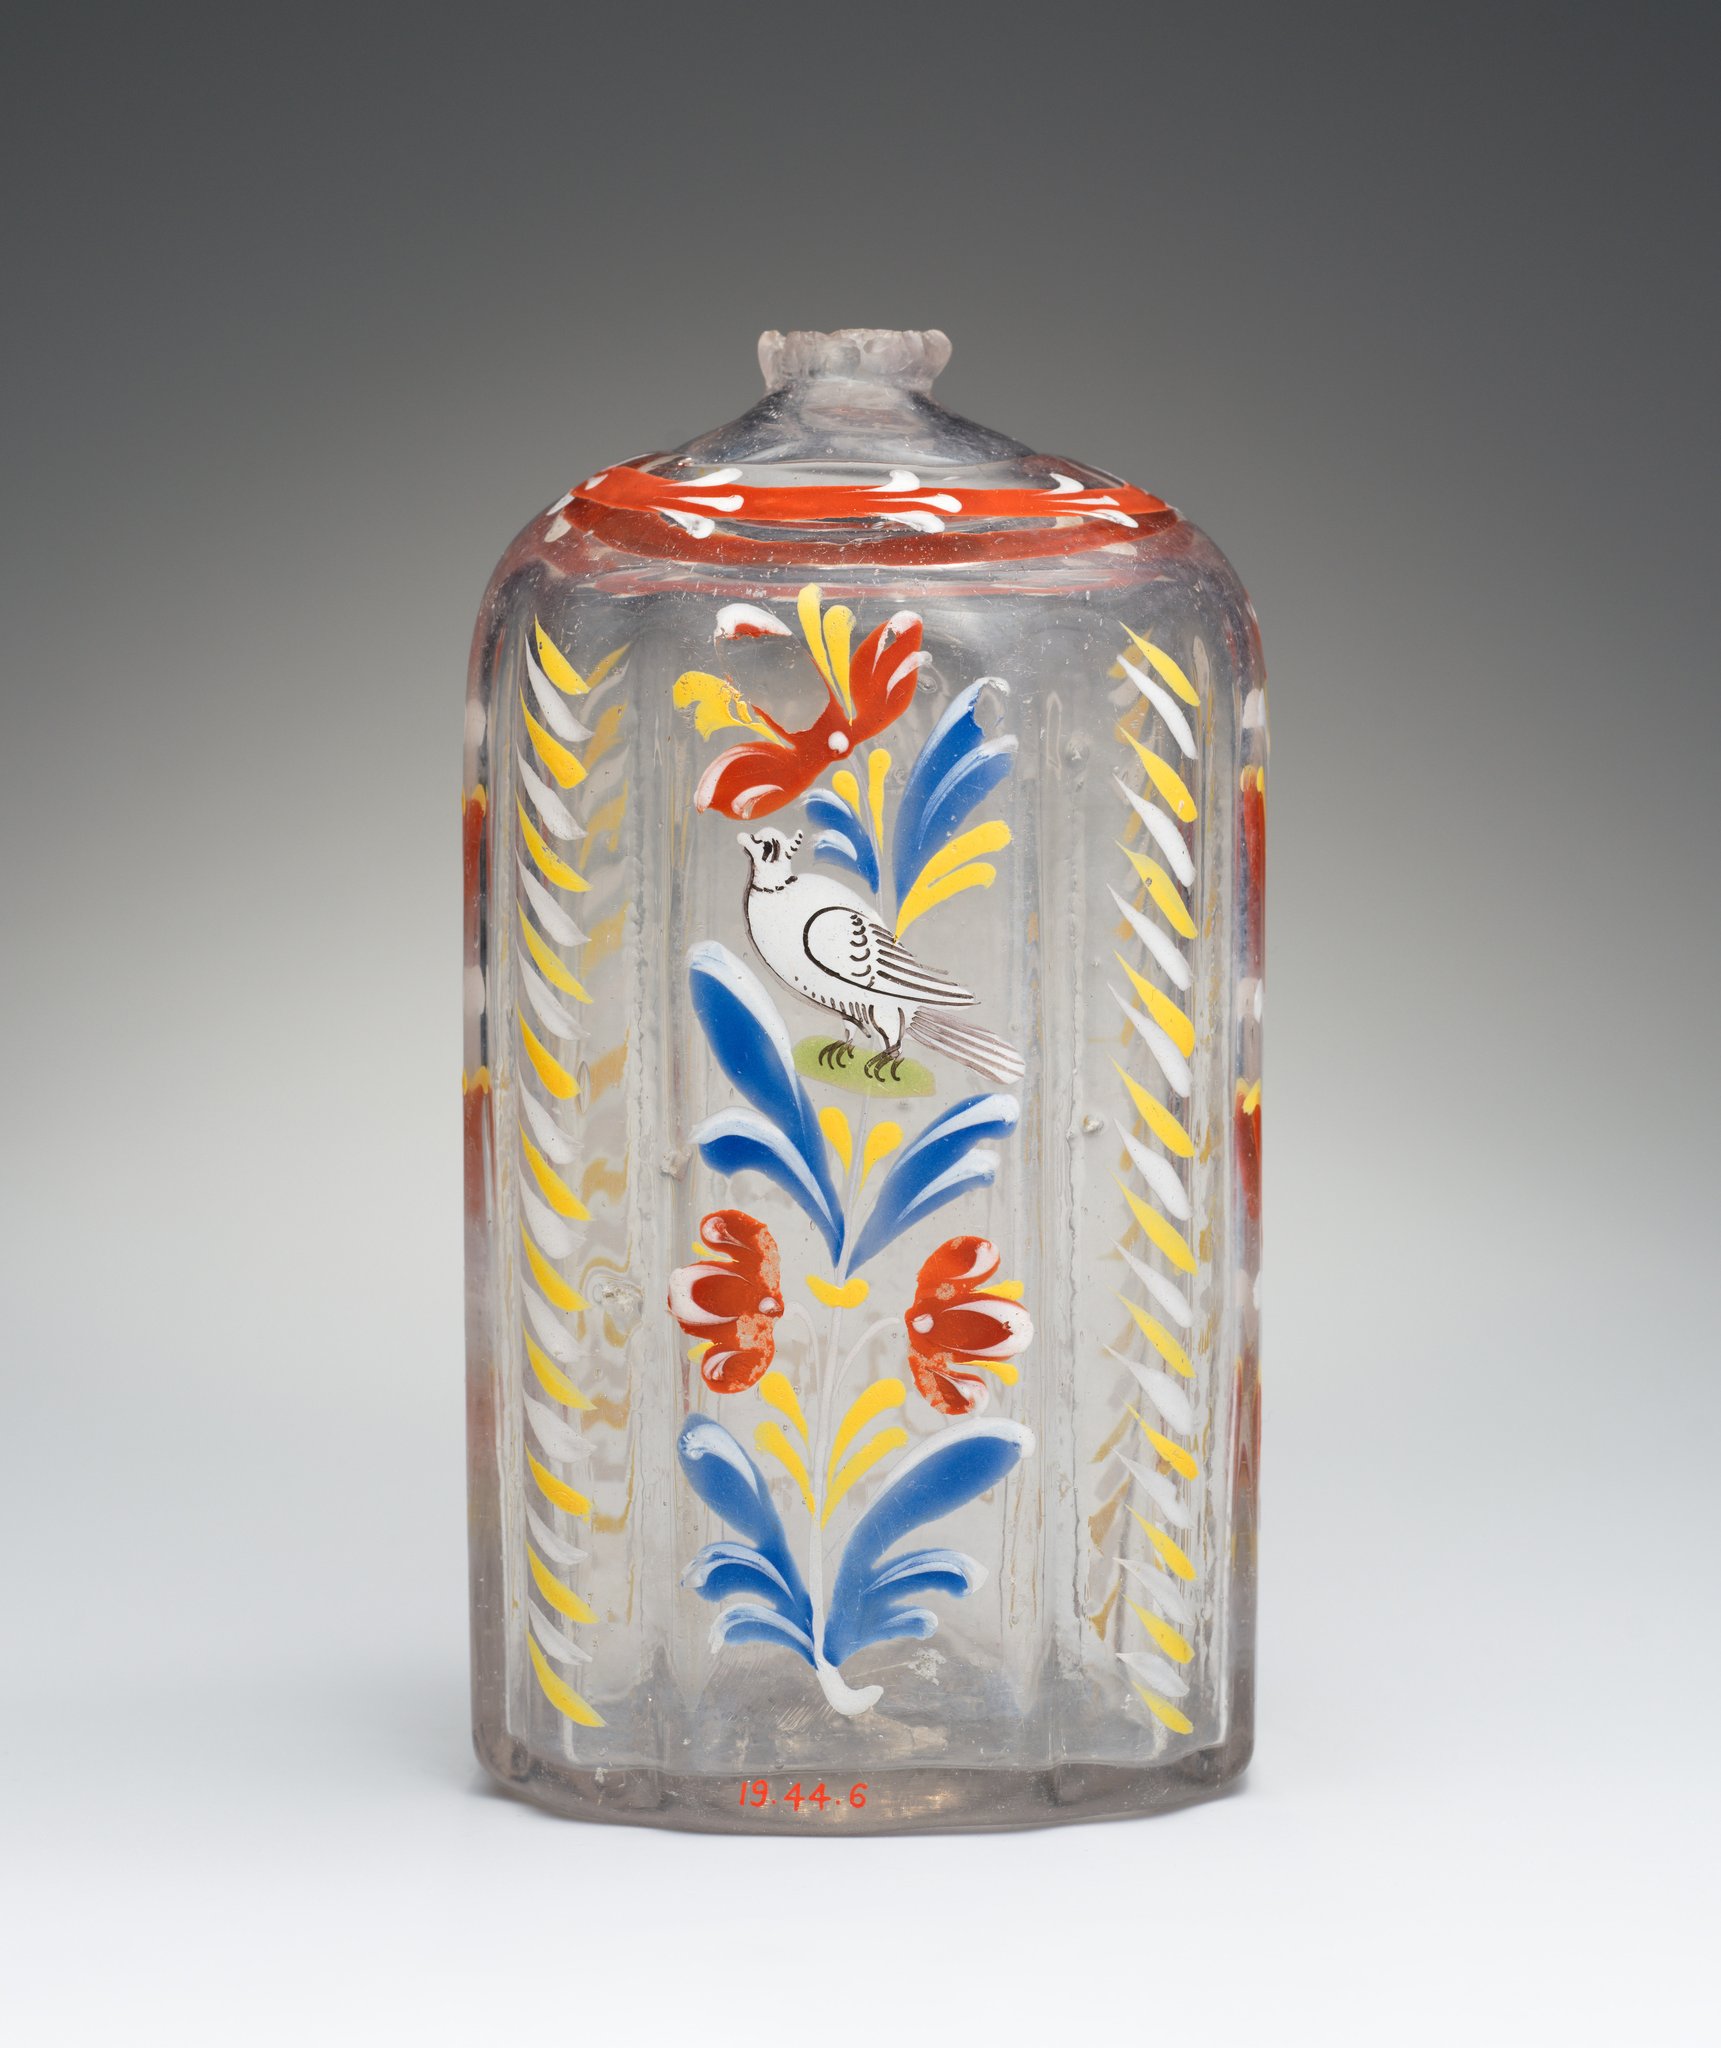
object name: bottle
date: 1801-1833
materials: glass, pewter